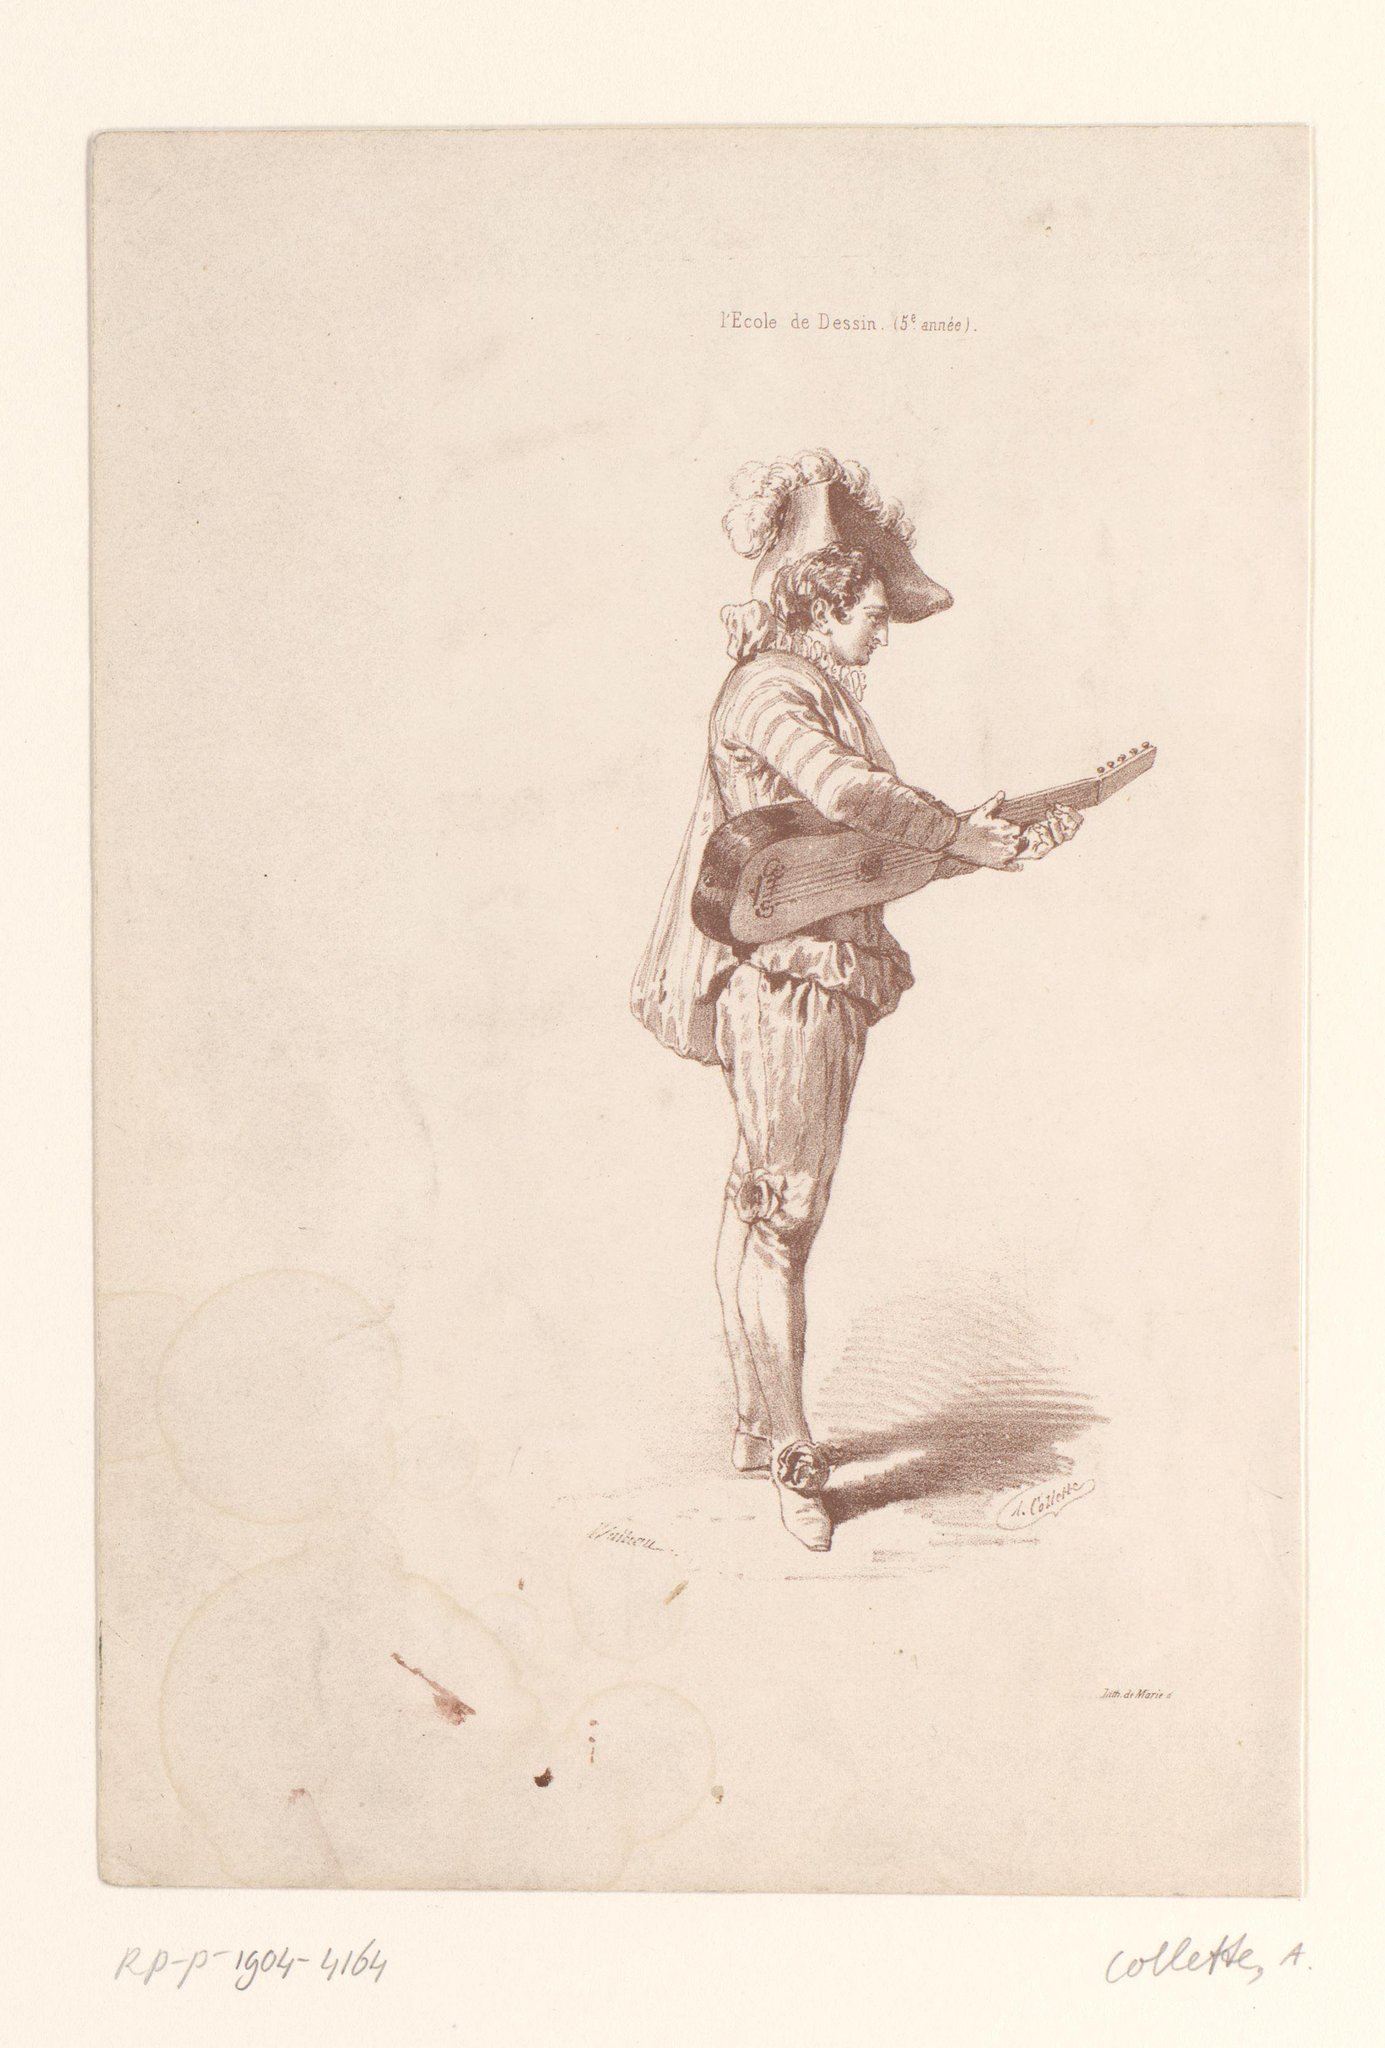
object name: print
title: Luitspeler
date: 1836-1869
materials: paper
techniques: lithograph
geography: paris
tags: lute, and special forms of lute, e.g.: theorbo, one person playing an instrument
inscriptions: collector's mark: Lugt 2228a